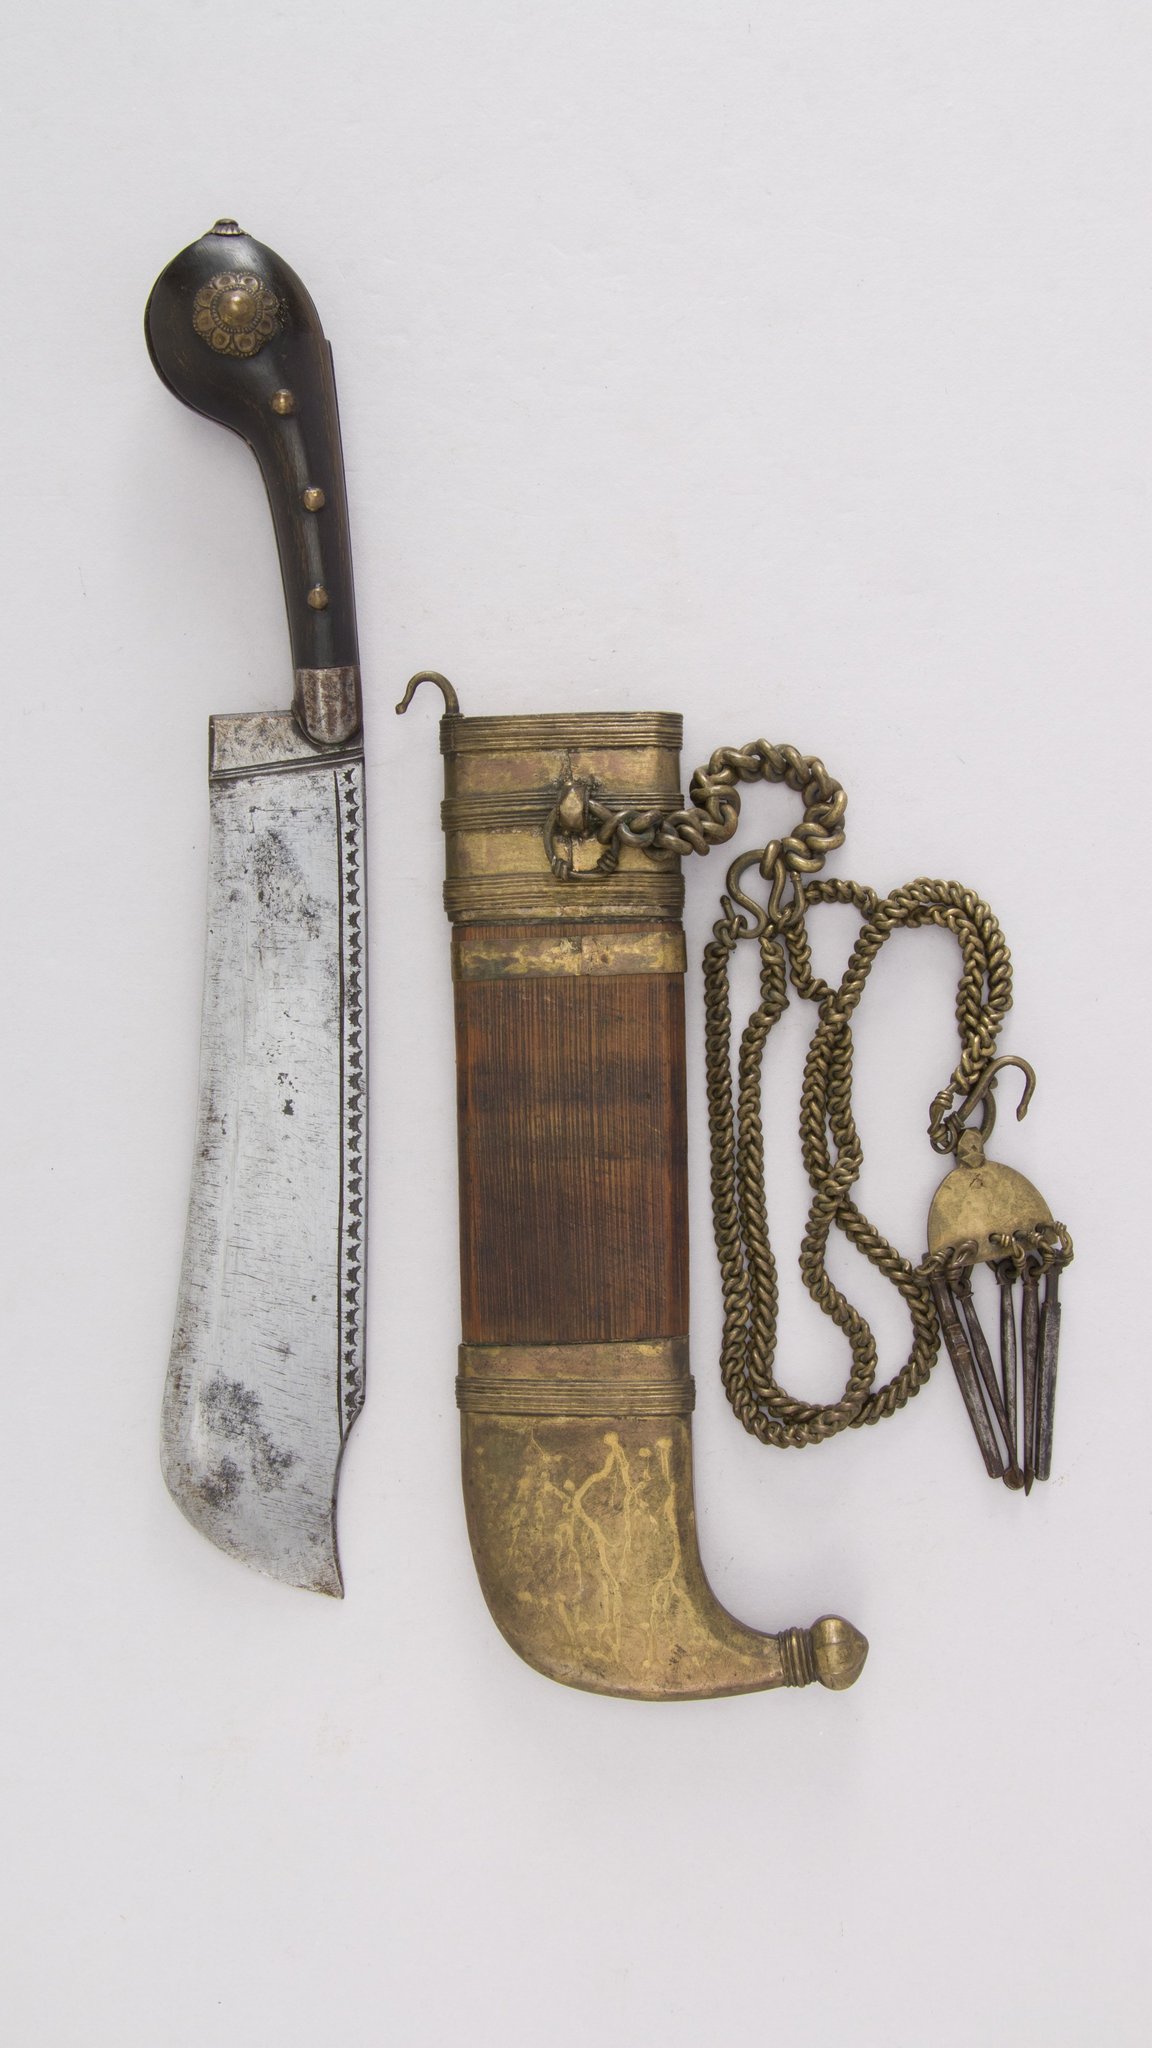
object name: knife pichangatti with sheath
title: Knife (Pichangatti) with Sheath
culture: indian, kodagu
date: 1701-1900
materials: brass, horn, steel, wood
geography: india